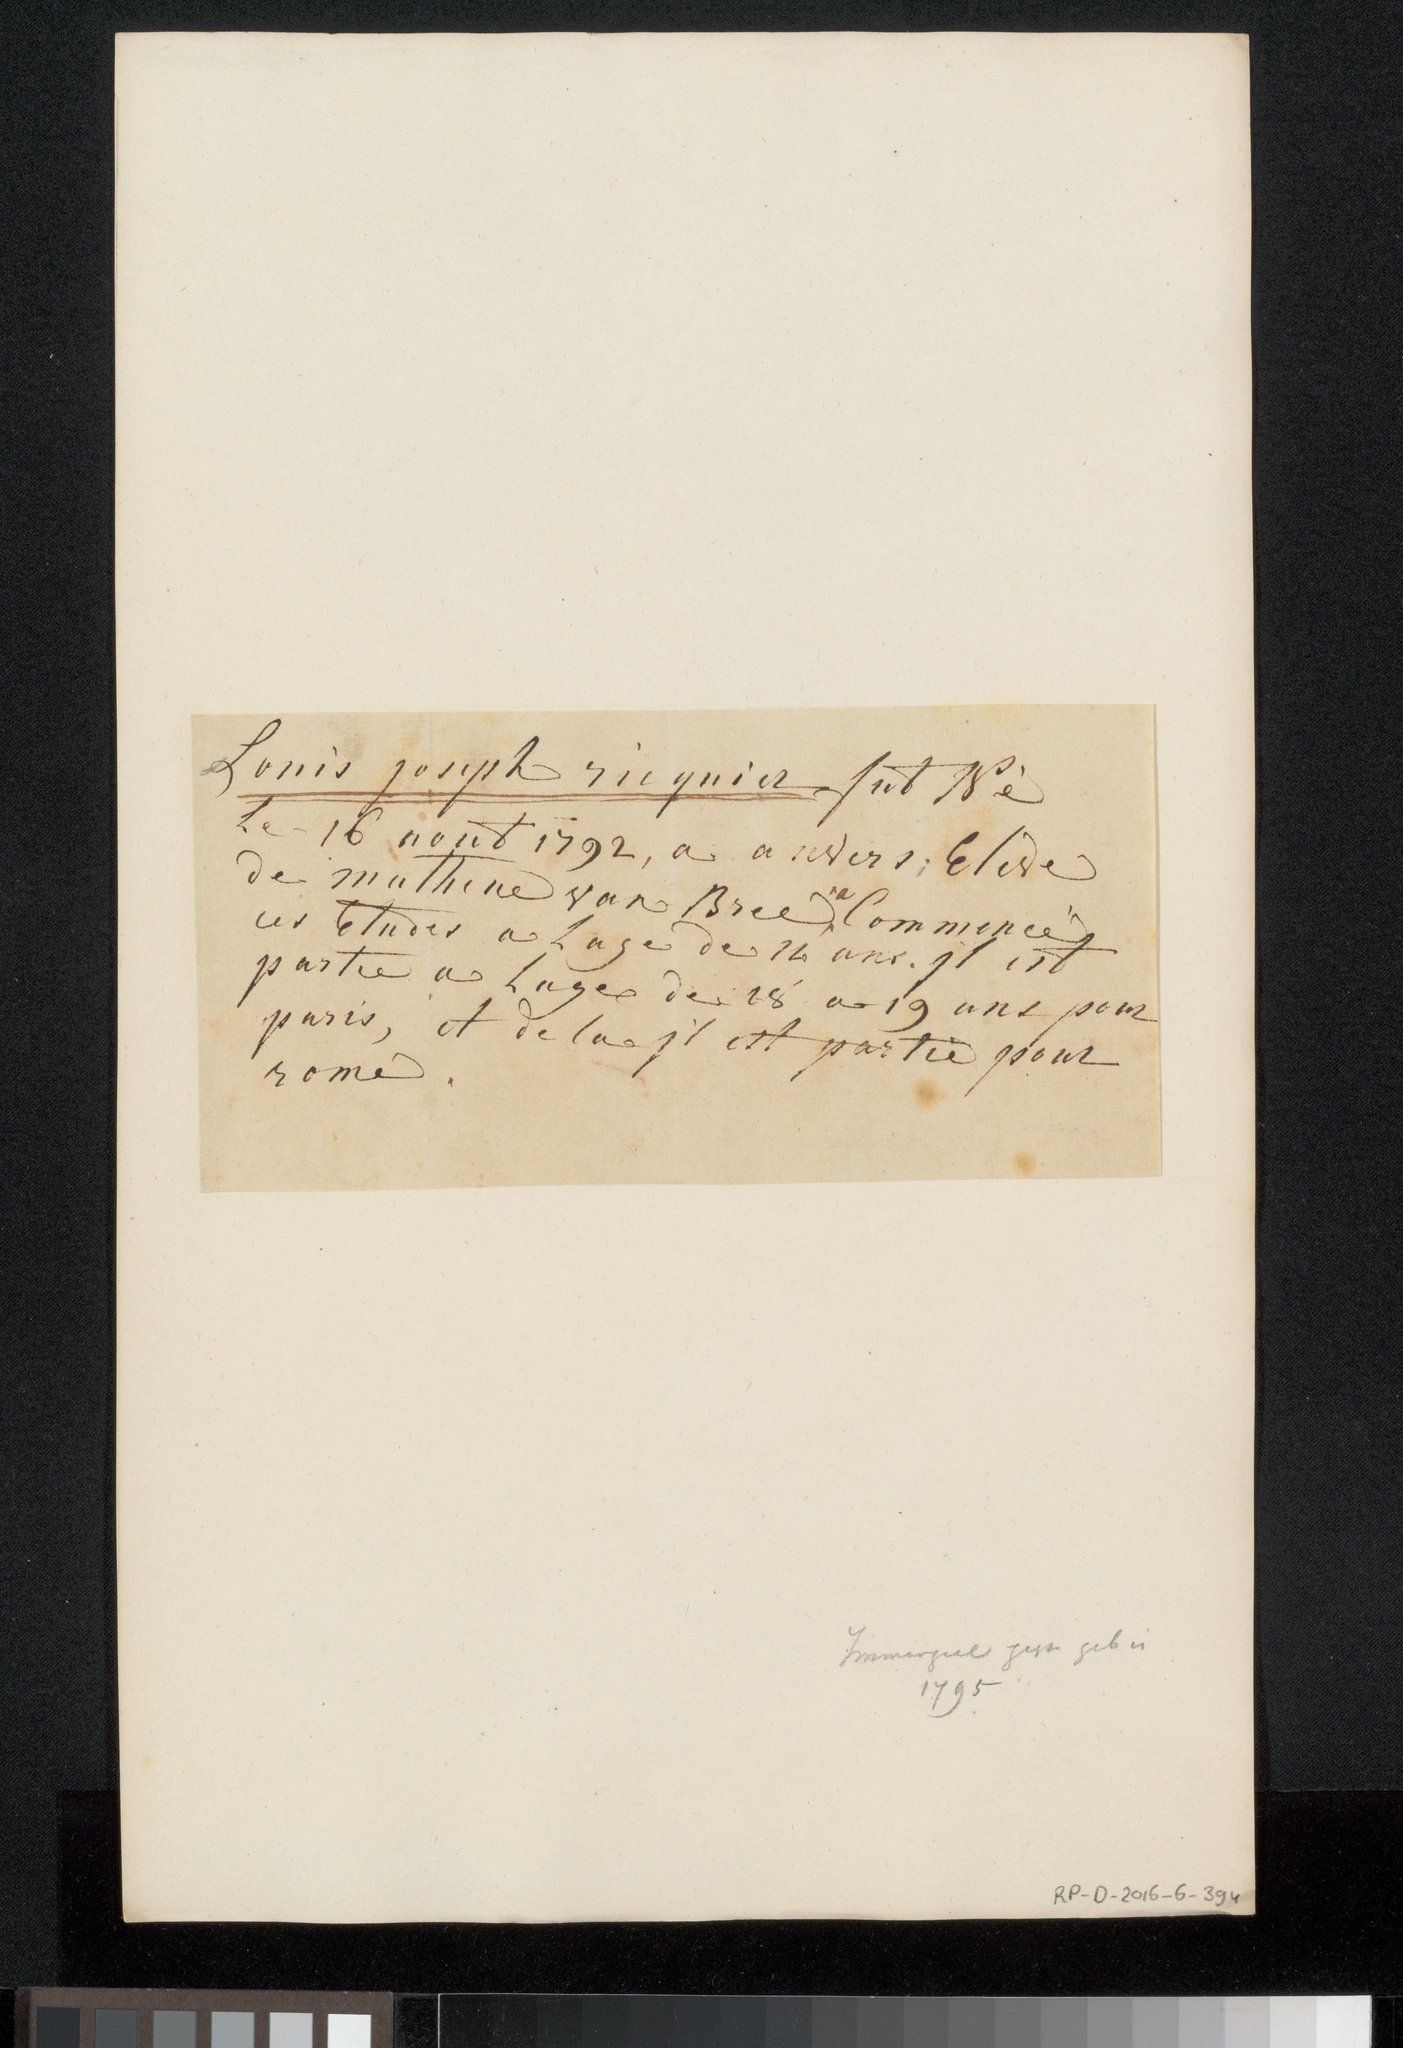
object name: manuscript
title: Handschrift betreffende Louis Ricquier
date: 1840-1841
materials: ink, paper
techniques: pen, writing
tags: antwerp, paris, painter, louis ricquier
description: Opgenomen in: Immerzeel, J. Jr., De levens en werken der Hollandsche en Vlaamsche kunstschilders, beeldhouwers, graveurs en bouwmeesters, van het begin der vijftiende eeuw tot heden, Amsterdam: J.C. van Kesteren, 1842-1843.